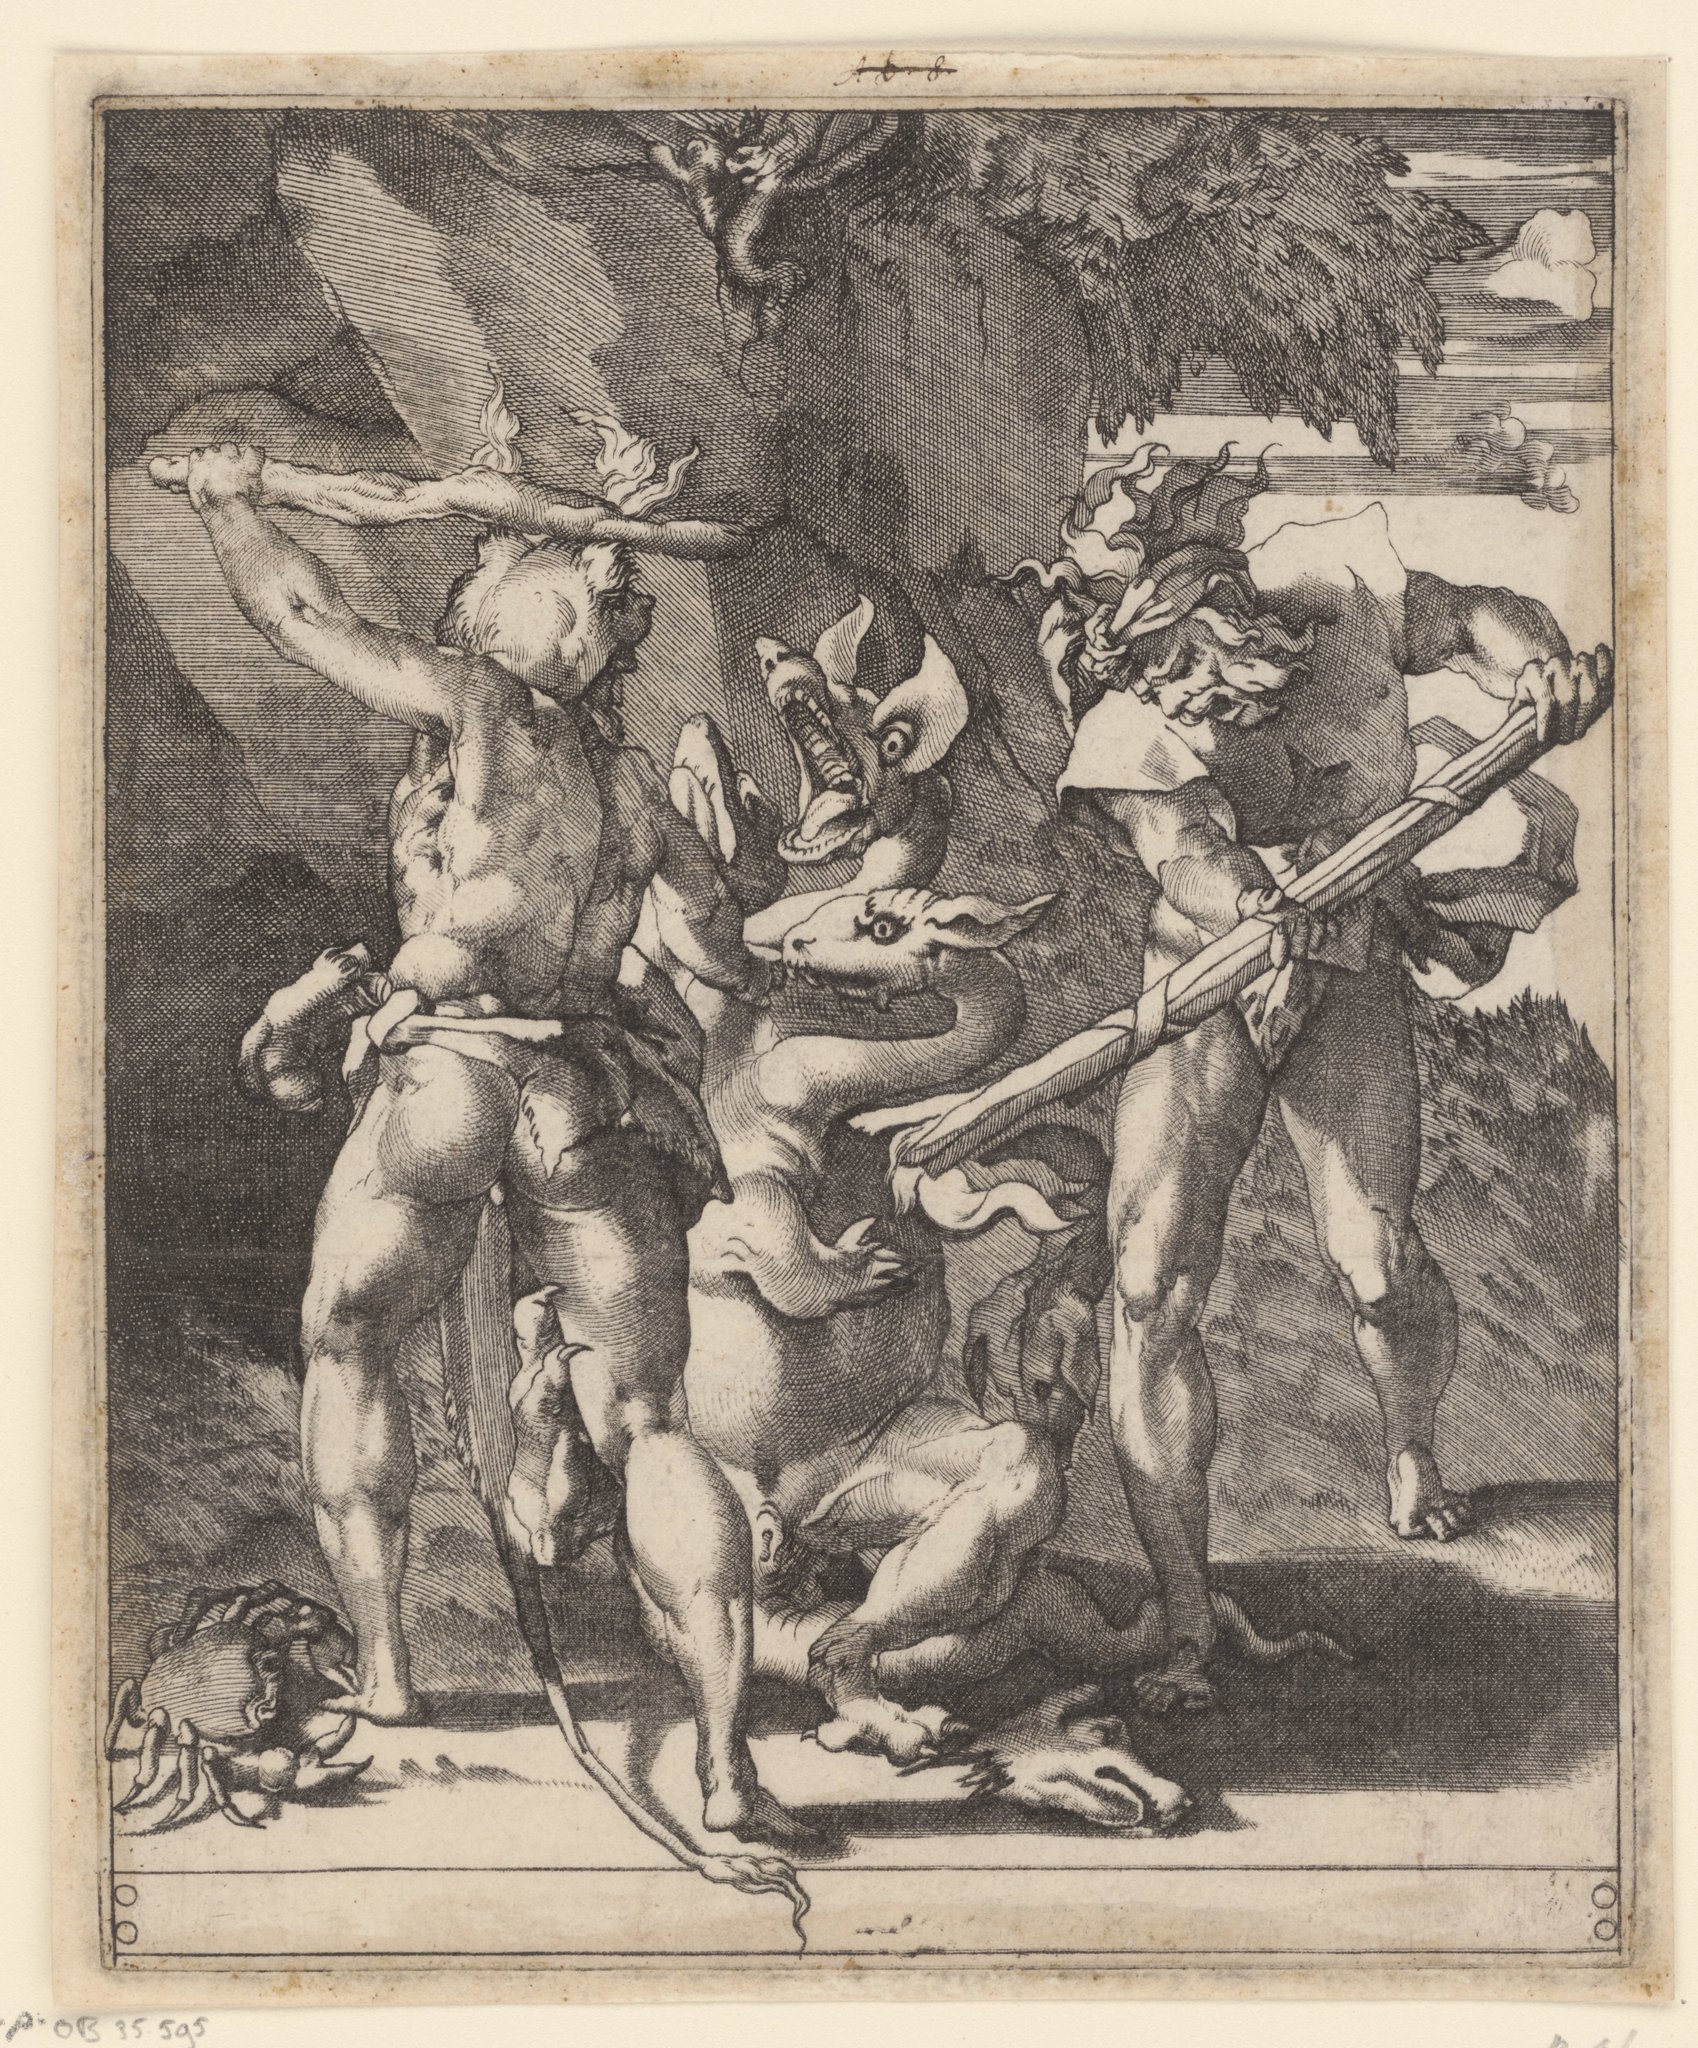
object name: print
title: Scènes met Hercules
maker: giovanni jacopo caraglio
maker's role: goldsmith, print maker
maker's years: 1500-1565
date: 1515-1565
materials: paper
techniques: engraving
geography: italy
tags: (2) the hydra of lerna is killed by hercules, the hydra is killed by hercules assisted by iolaus, who sears the roots of the severed heads with burning brands; an enormous crab nips hercules' foot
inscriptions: collector's mark: Lugt 240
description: Hercules en een metgezel (mogelijk Iolaus) gaan met knots en brandende fabbel de meerkoppige hydra van Lerna te lijf.